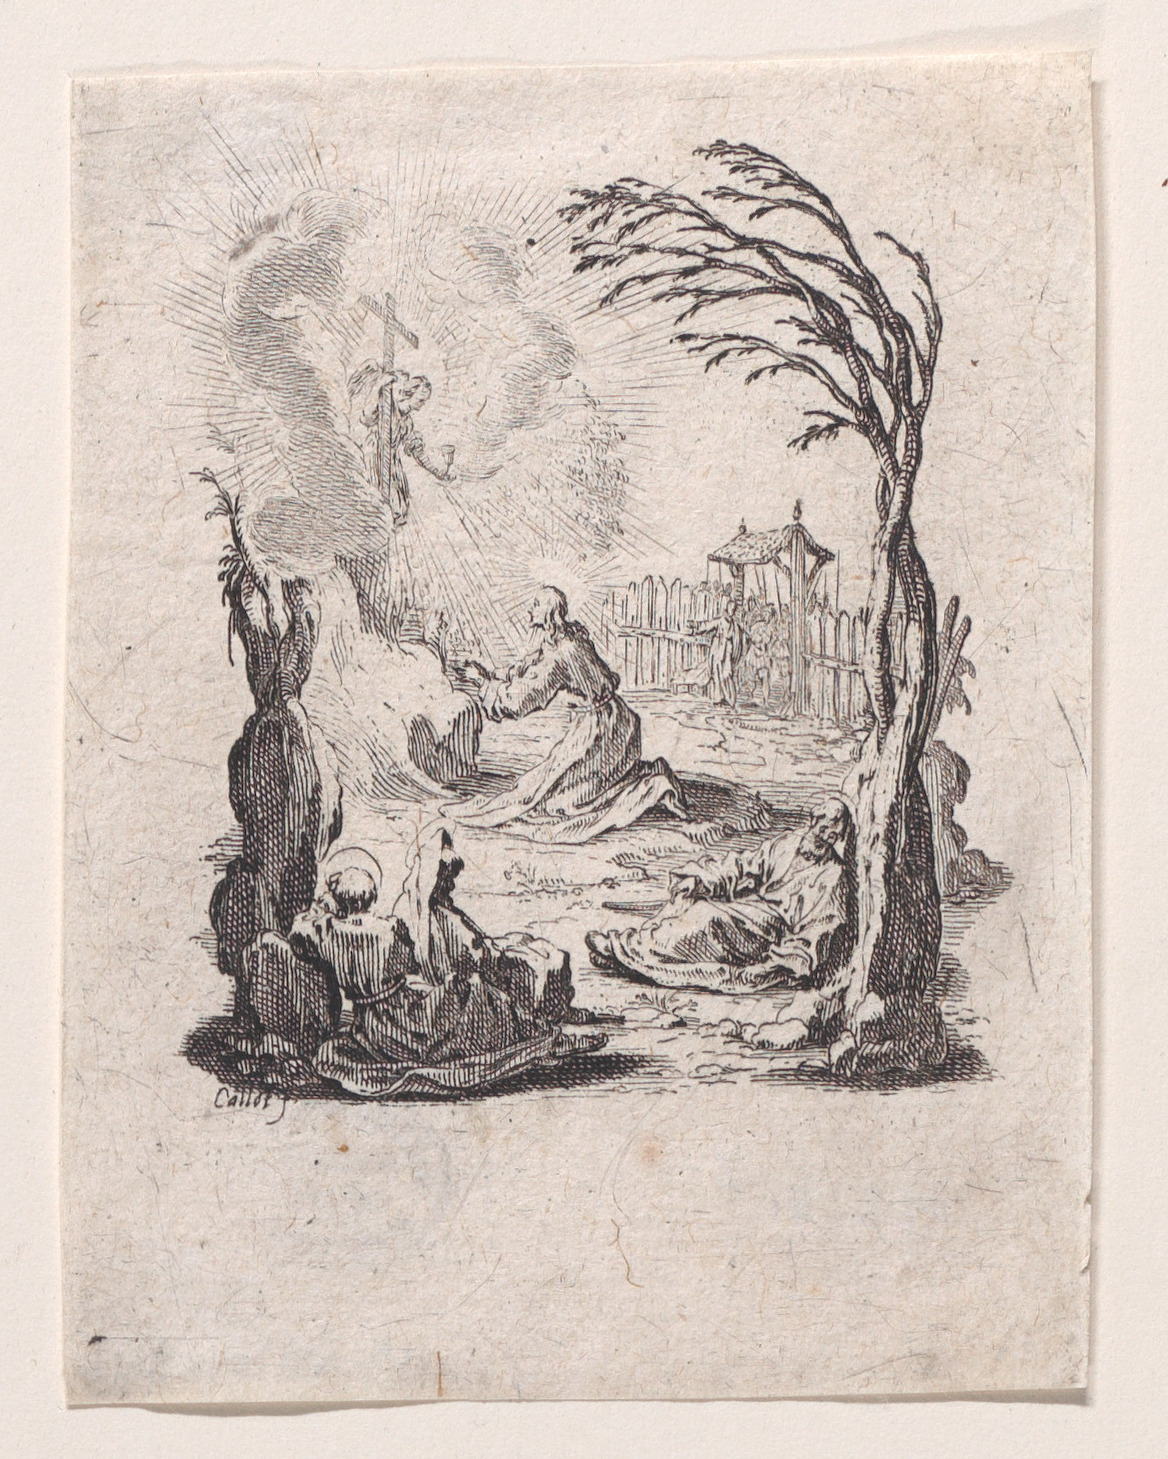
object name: print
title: Jésus au Jardin des Oliviers (Jesus in the Garden of Olives), from "La Petite Passion" (The Little Passion)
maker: jacques callot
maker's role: artist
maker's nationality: french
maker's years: 1592-1635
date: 1624-1625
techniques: etching